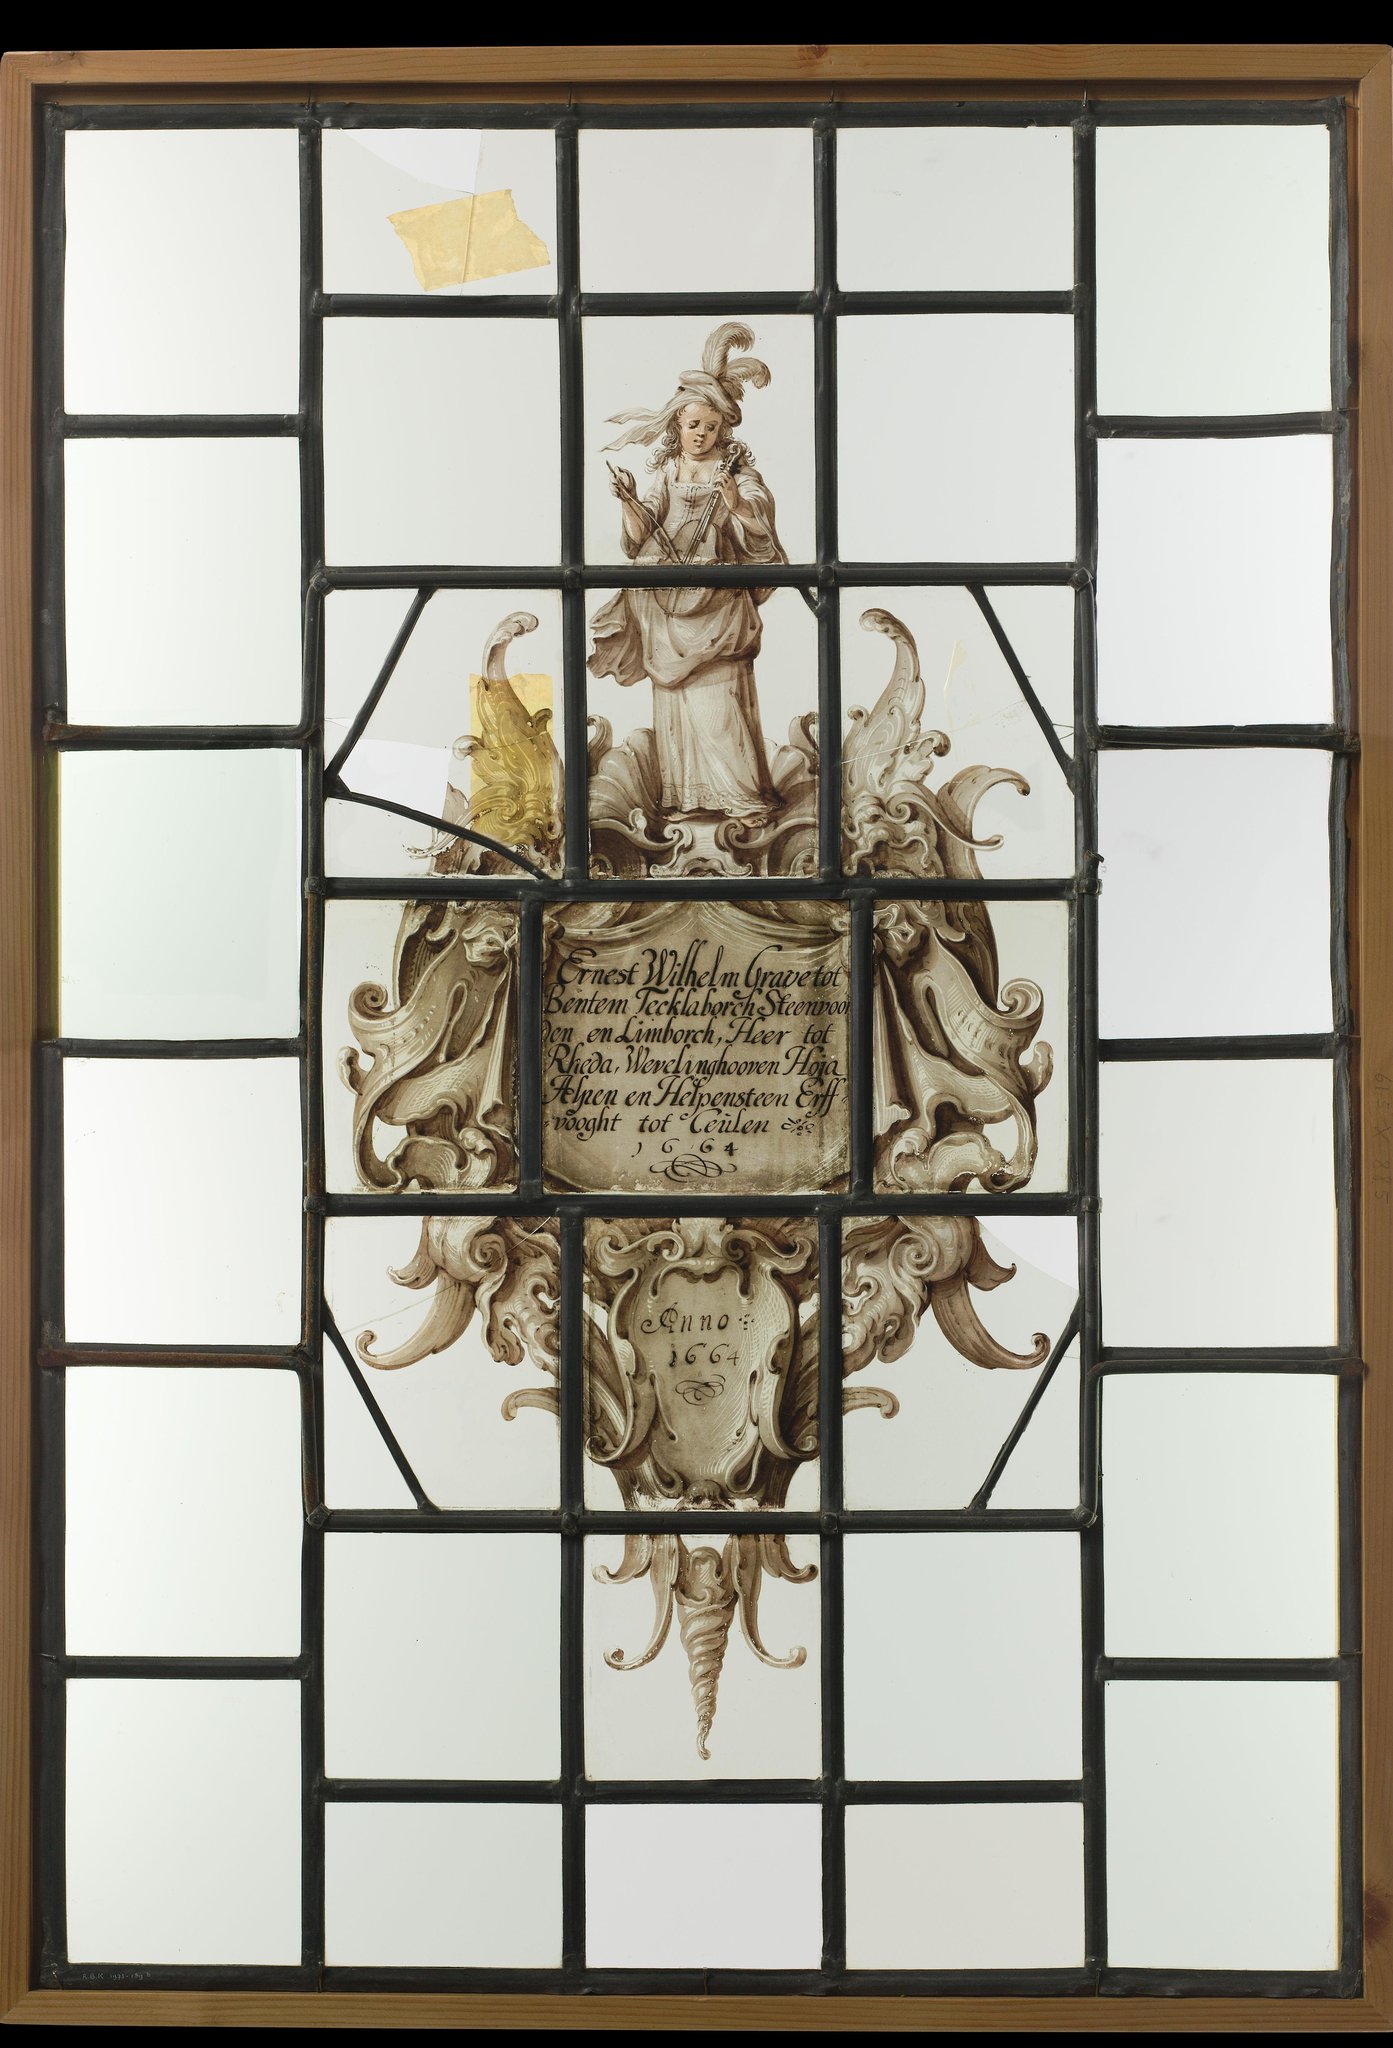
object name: wapenruit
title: Ruit met cartouche in kwabstijl met wapen en tekst "Ernest Wilhelm Grave tot Bentem Tecklaborch Steenvoorden en Limborch, Heer tot Rheda... 1664"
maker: Anonymous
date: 1664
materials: glass, lead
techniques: leading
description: Gebrandschilderde ruit in grisaille en vleeskleur met cartouche in kwabstijl waarboven een vrouwenfiguur. In cartouche familiewqapen met tekst: Ernest Wilhelm Grave tot Bentem Tecklaborch Steenvoorden en Limborch, Heer tot Rheda, Wevelinghooven Hoja Alpen en Helpensteen Erffvooght tot Cuelen 1664; daaronder nogeens Anno 1664